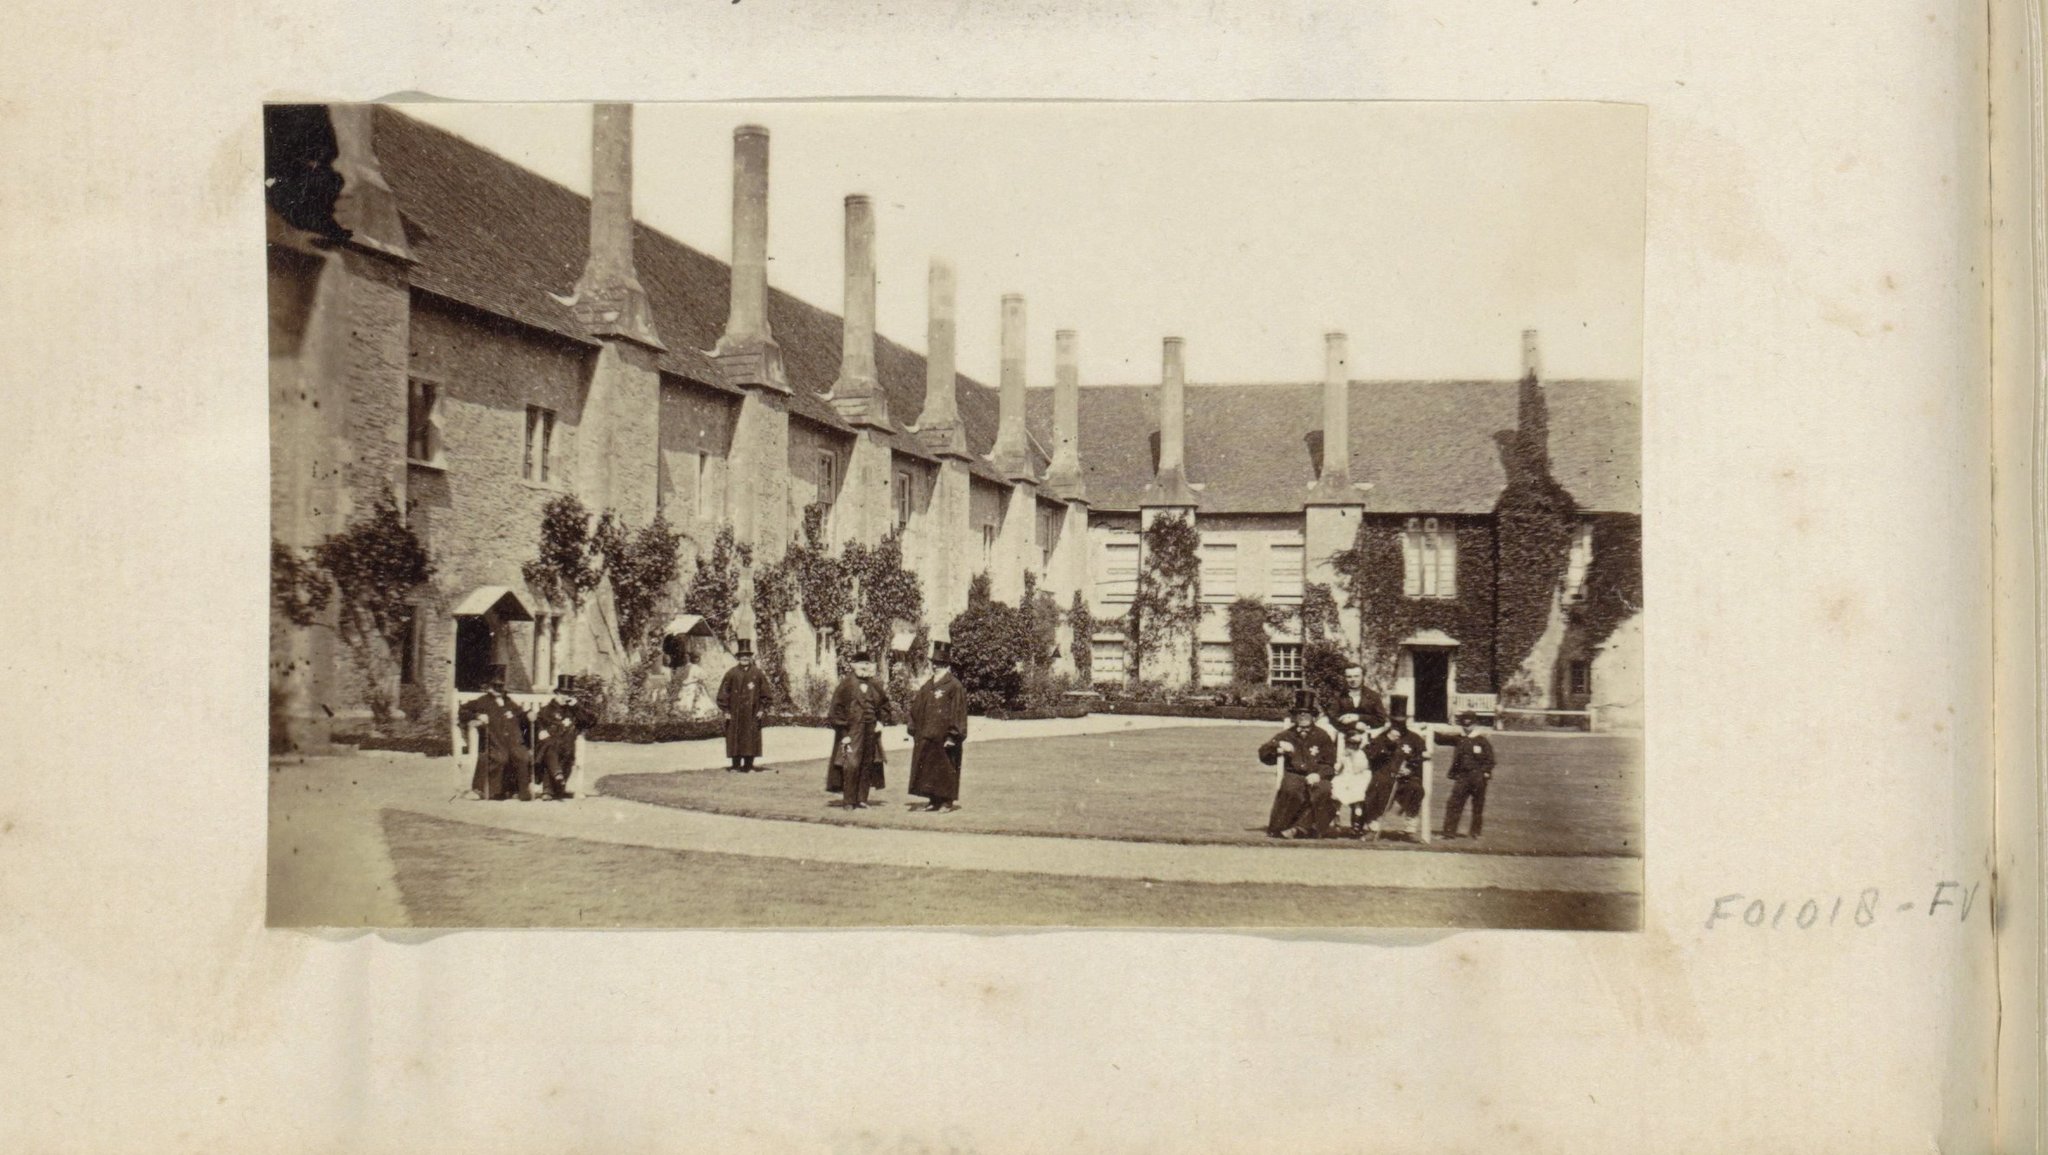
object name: photograph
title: Oudere mannen op een grasveld voor een landhuis, vermoedelijk in Groot-Brittannië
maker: Anonymous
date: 1860-1870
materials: paper, photographic support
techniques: albumen print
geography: great britain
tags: old man, courtyard, head-gear: top hat, great britain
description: Onderdeel van Engels familiealbum met foto's van personen, reizen, cricket en kunstwerken.